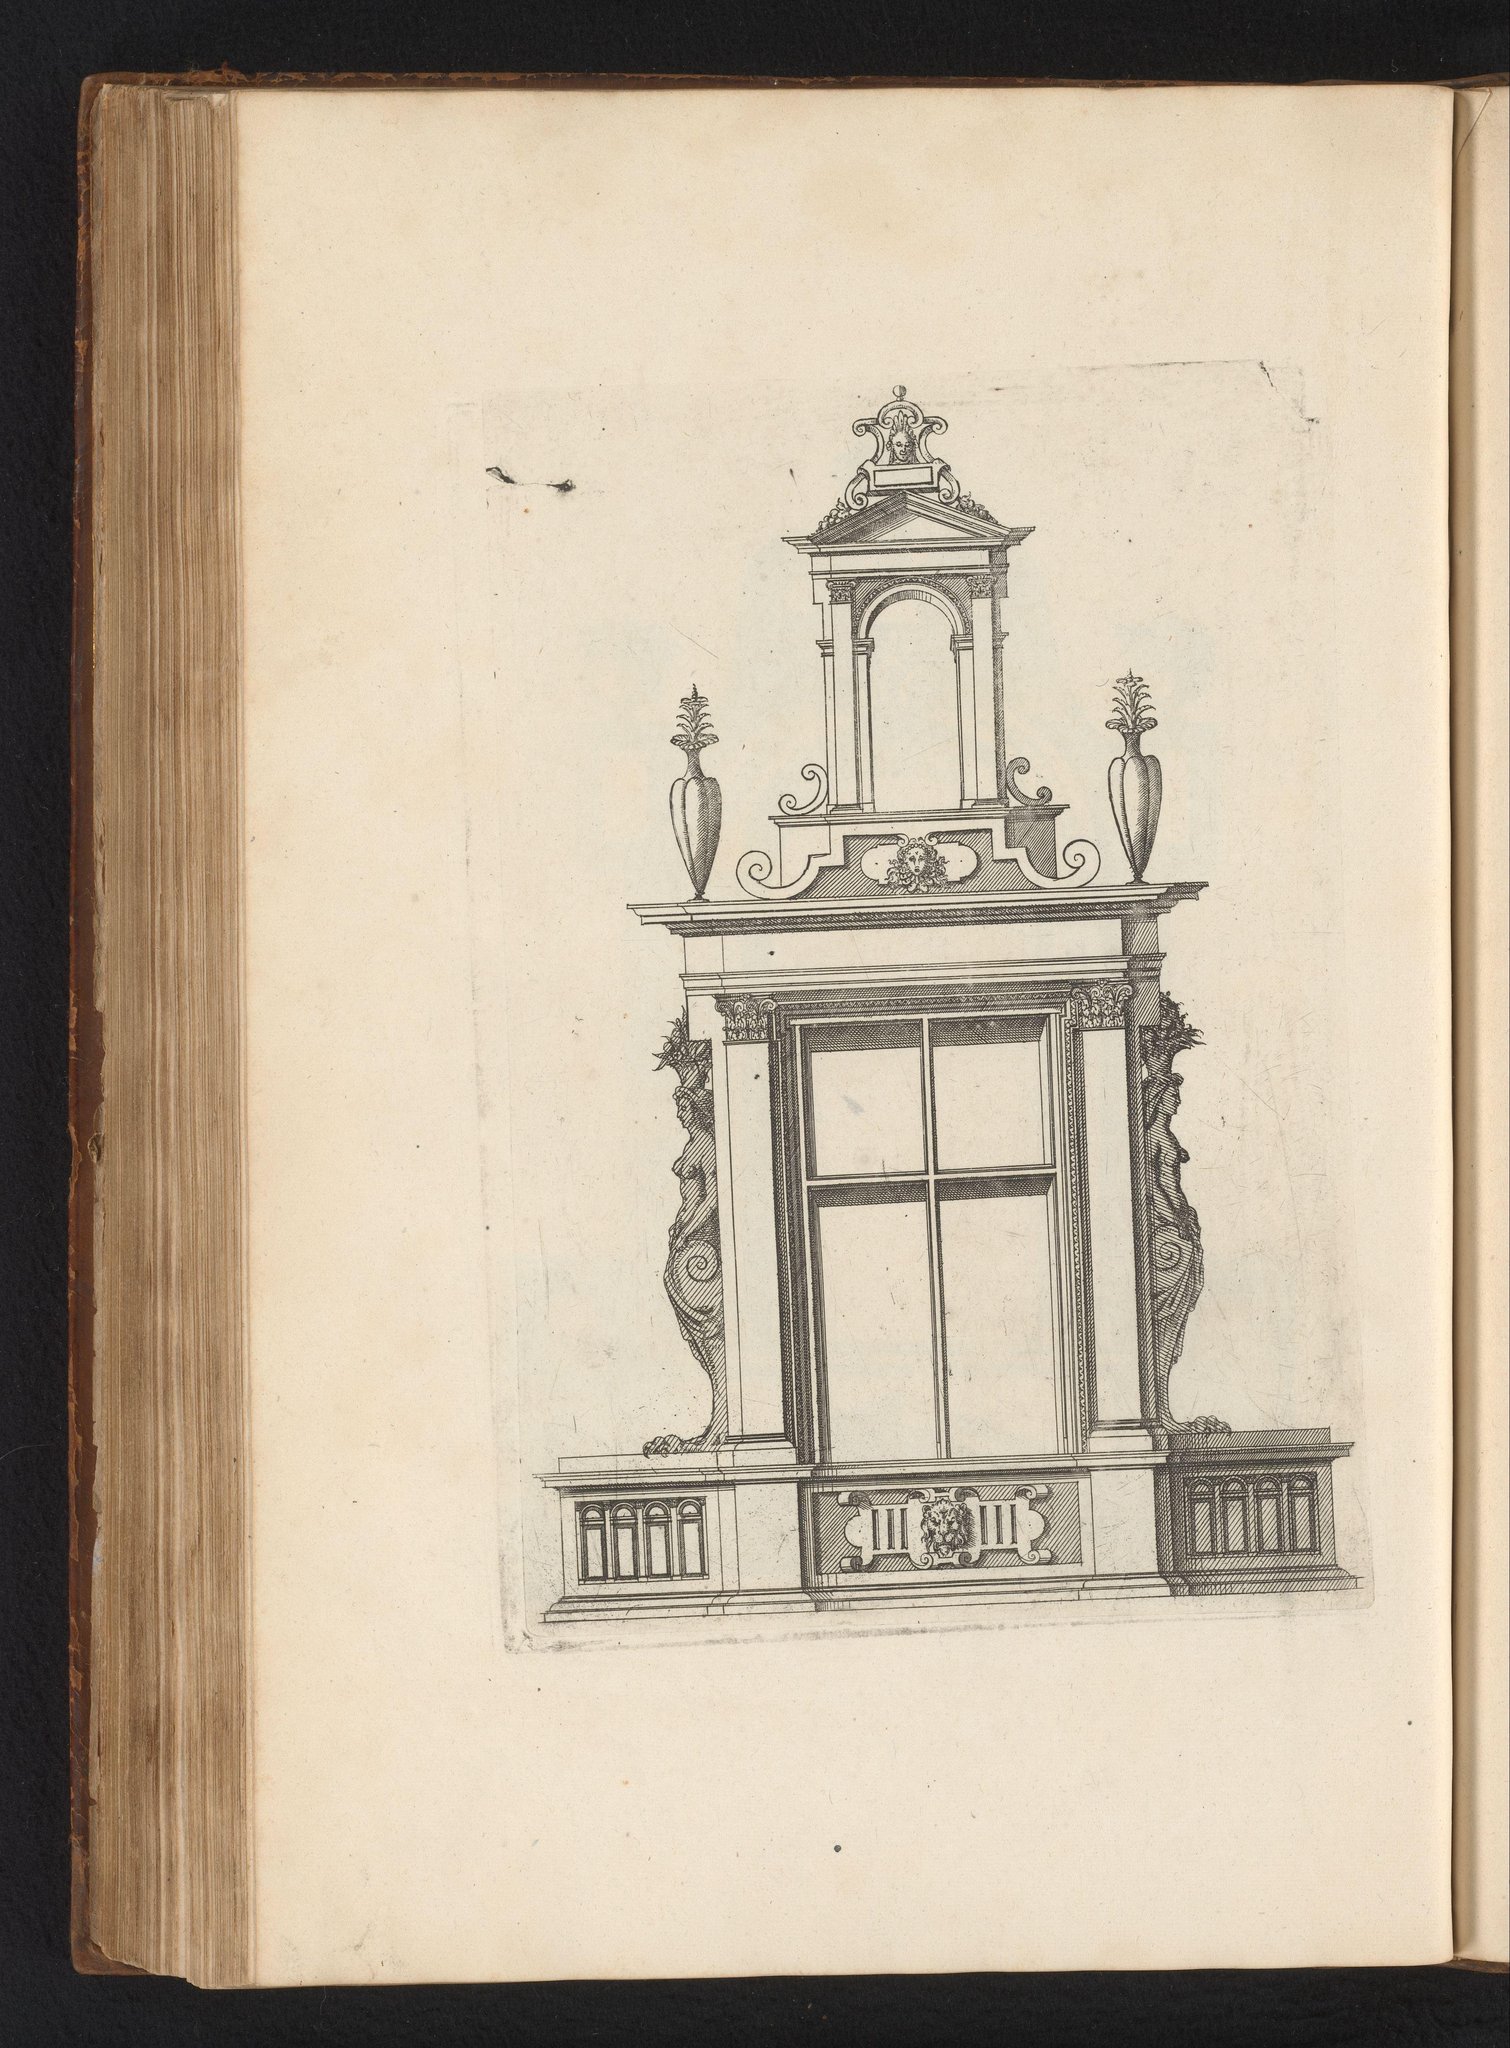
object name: ornament print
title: Dakraam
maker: jacques androuet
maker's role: draughtsman, print maker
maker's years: 1515-1584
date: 1561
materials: paper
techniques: etching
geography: paris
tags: window, caryatids ~ architecture, arch, archivolt ~ architecture, architectural design or model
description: Dakraam met kariatiden en bovenop een boog. Onderdeel van 'Seconde livre d'architectvre' (1561): 64 etsen met geornamenteerde architectuuronderdelen.